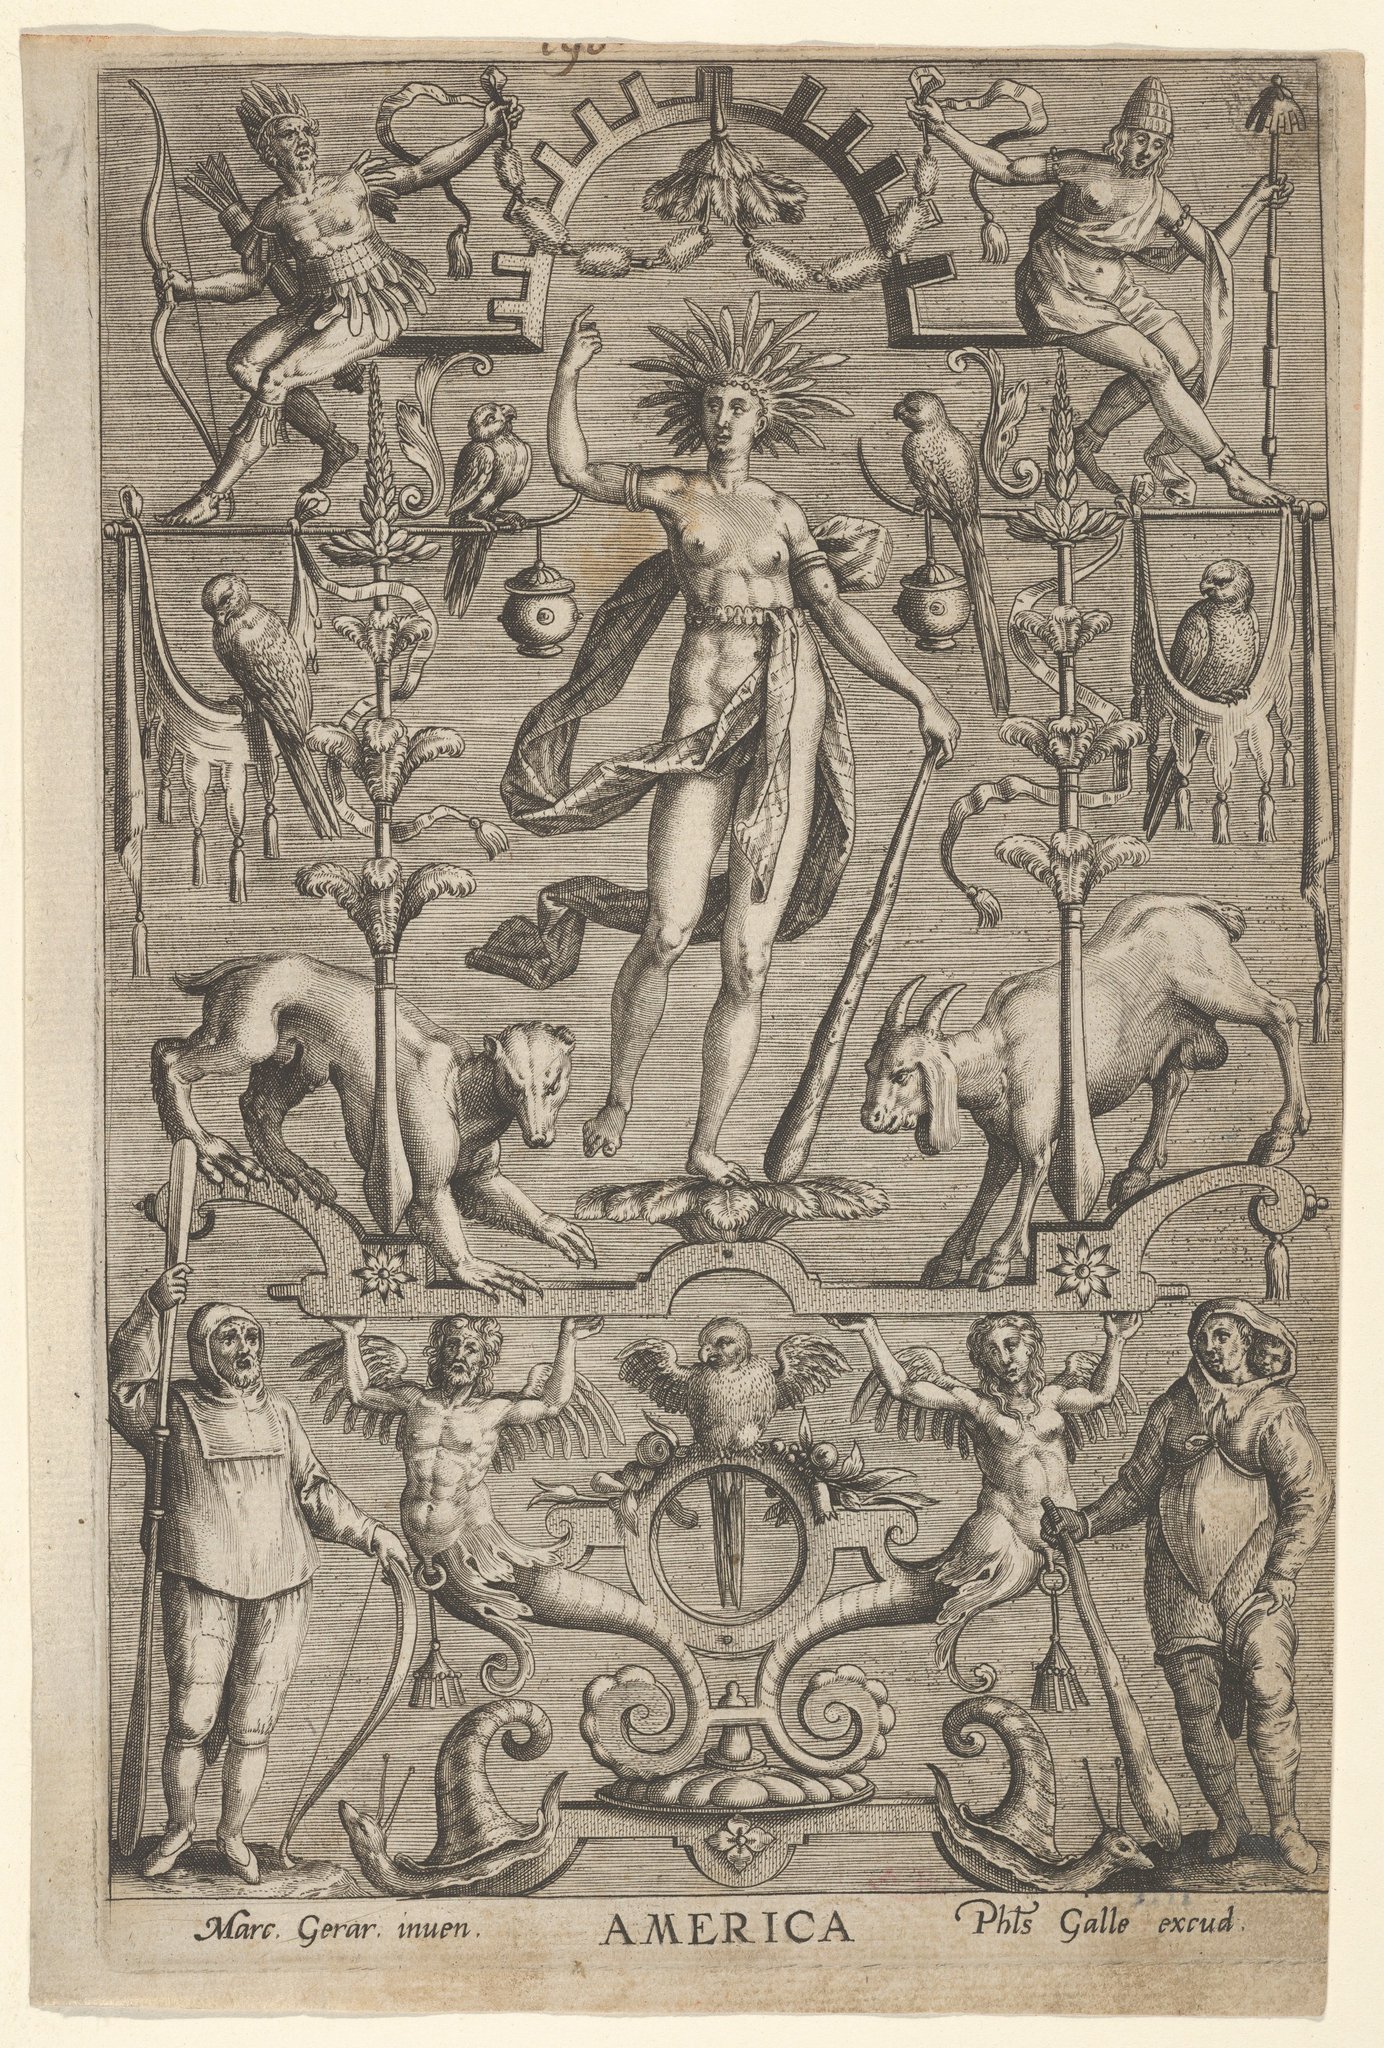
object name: print ornament architecture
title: Allegory of America, from "The Four Continents"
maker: marcus gheeraerts the elder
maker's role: artist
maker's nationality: flemish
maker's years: 1510-1600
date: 1590-1600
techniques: engraving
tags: animals,birds,men,goats